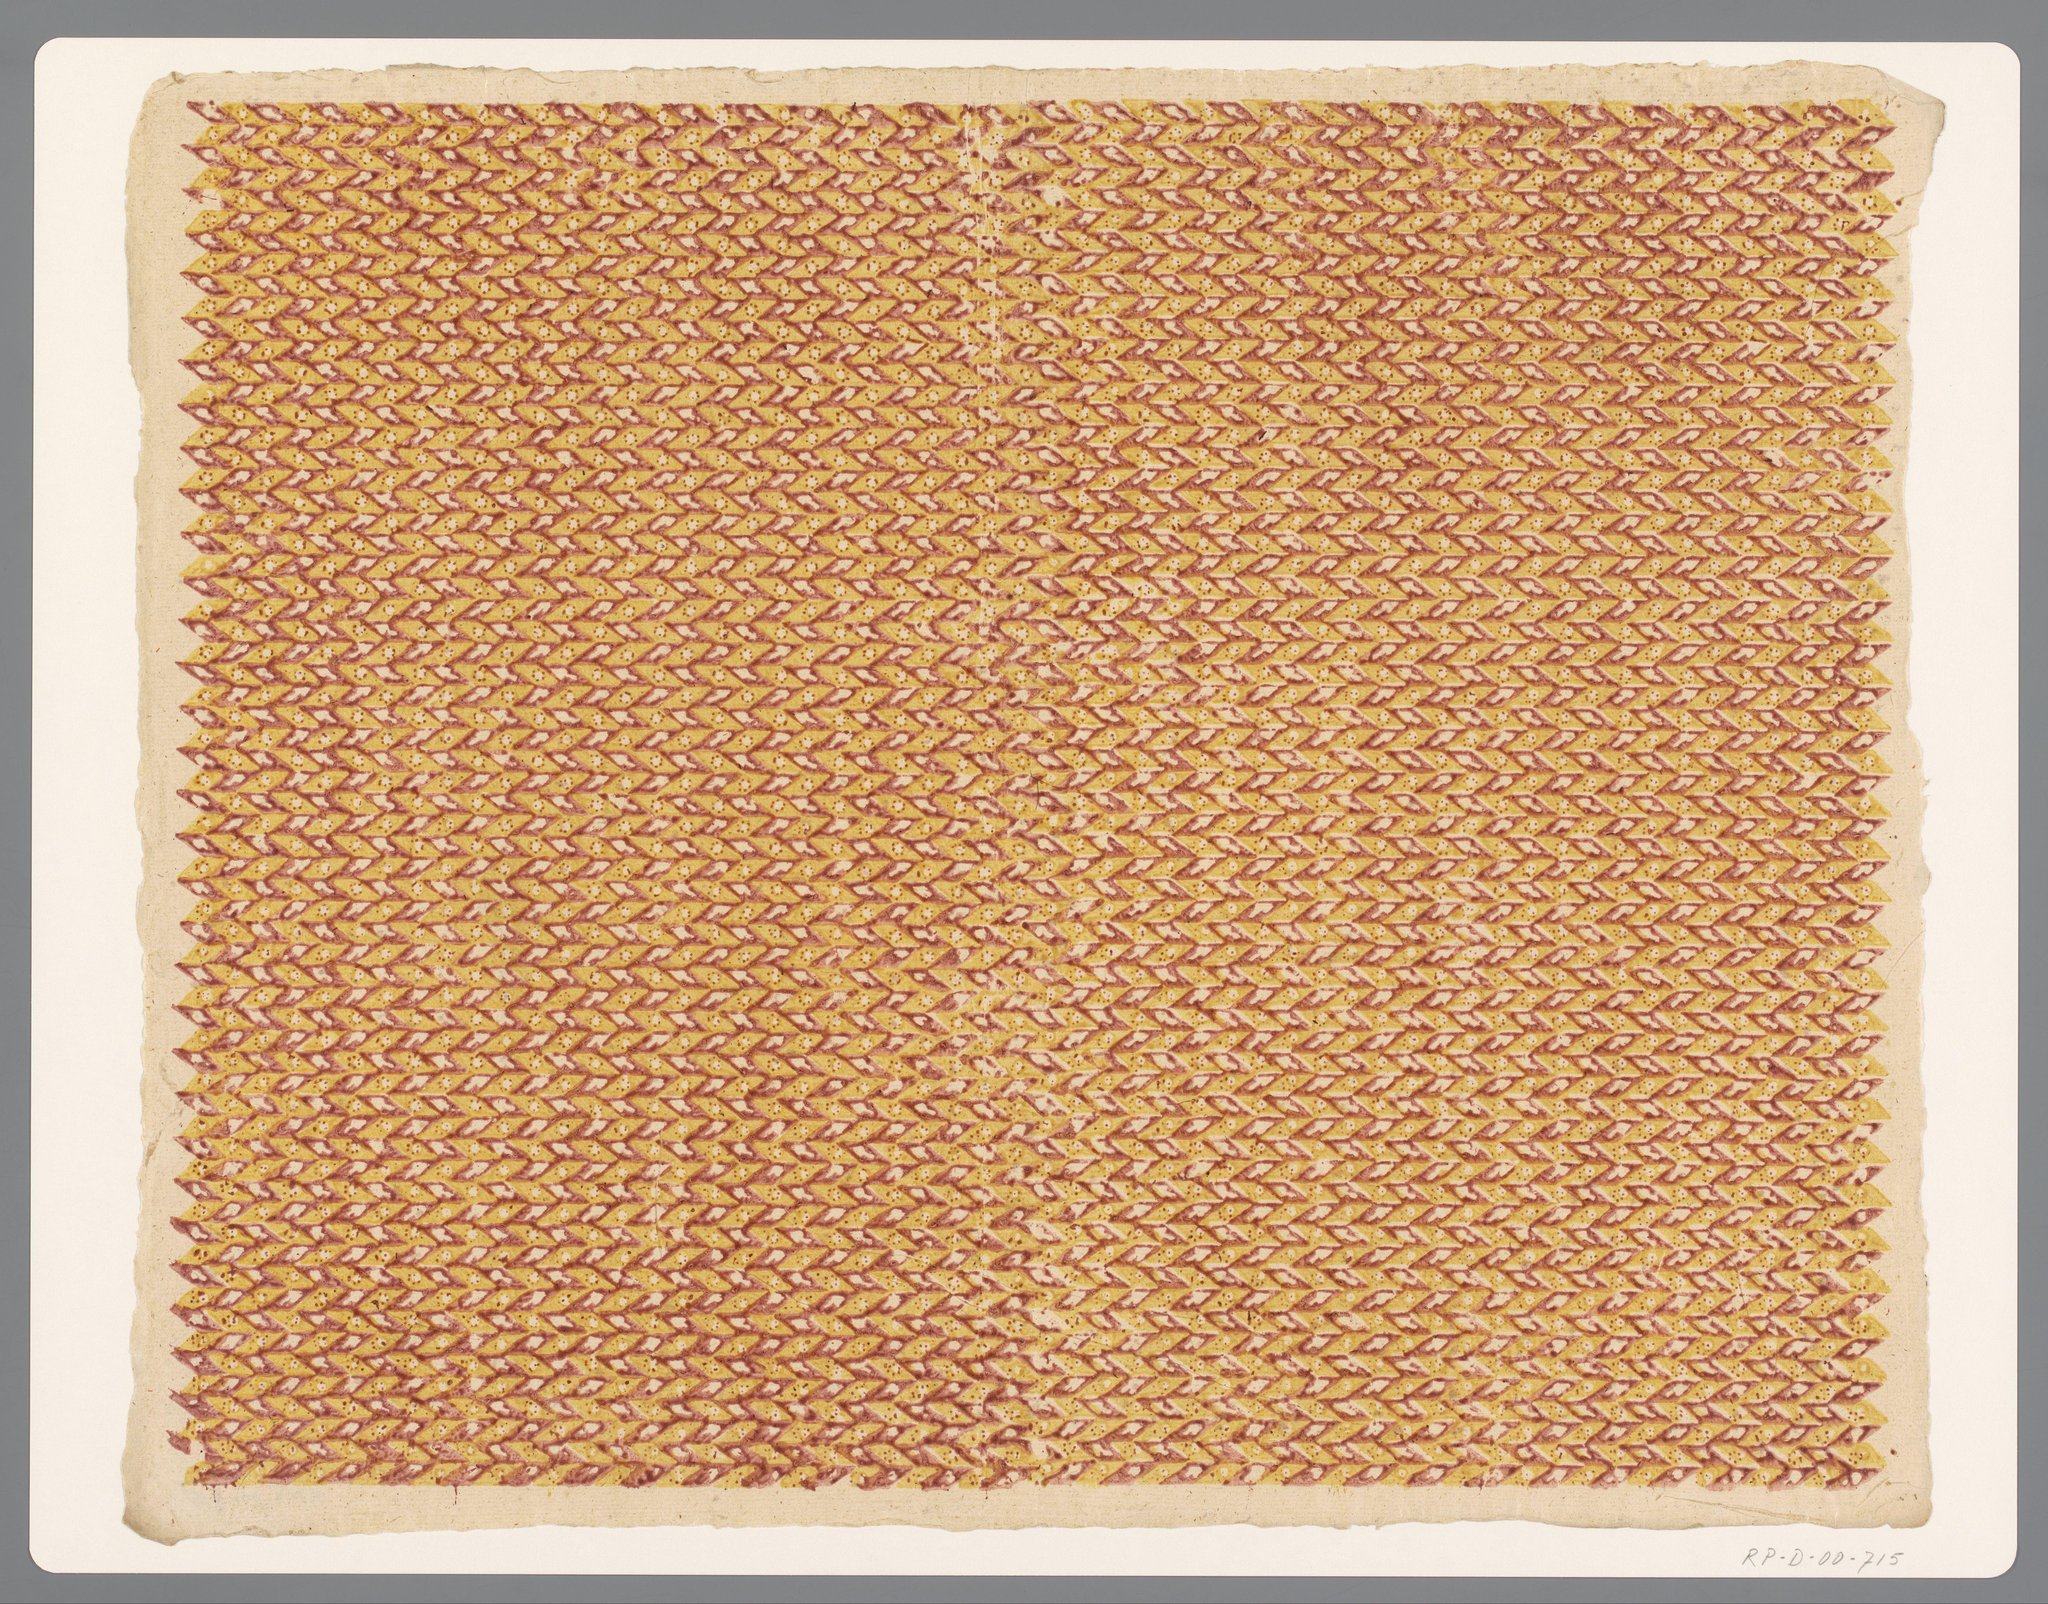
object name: printed paper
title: Blad met banenpatroon met afwisselend ruiten en stippen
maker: Anonymous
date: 1750-1900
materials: lacquer, paper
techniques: printing block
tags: ornament ~ geometric motifs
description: Blad met horizontaal banenpatroon met afwisselend ruiten en stippen.